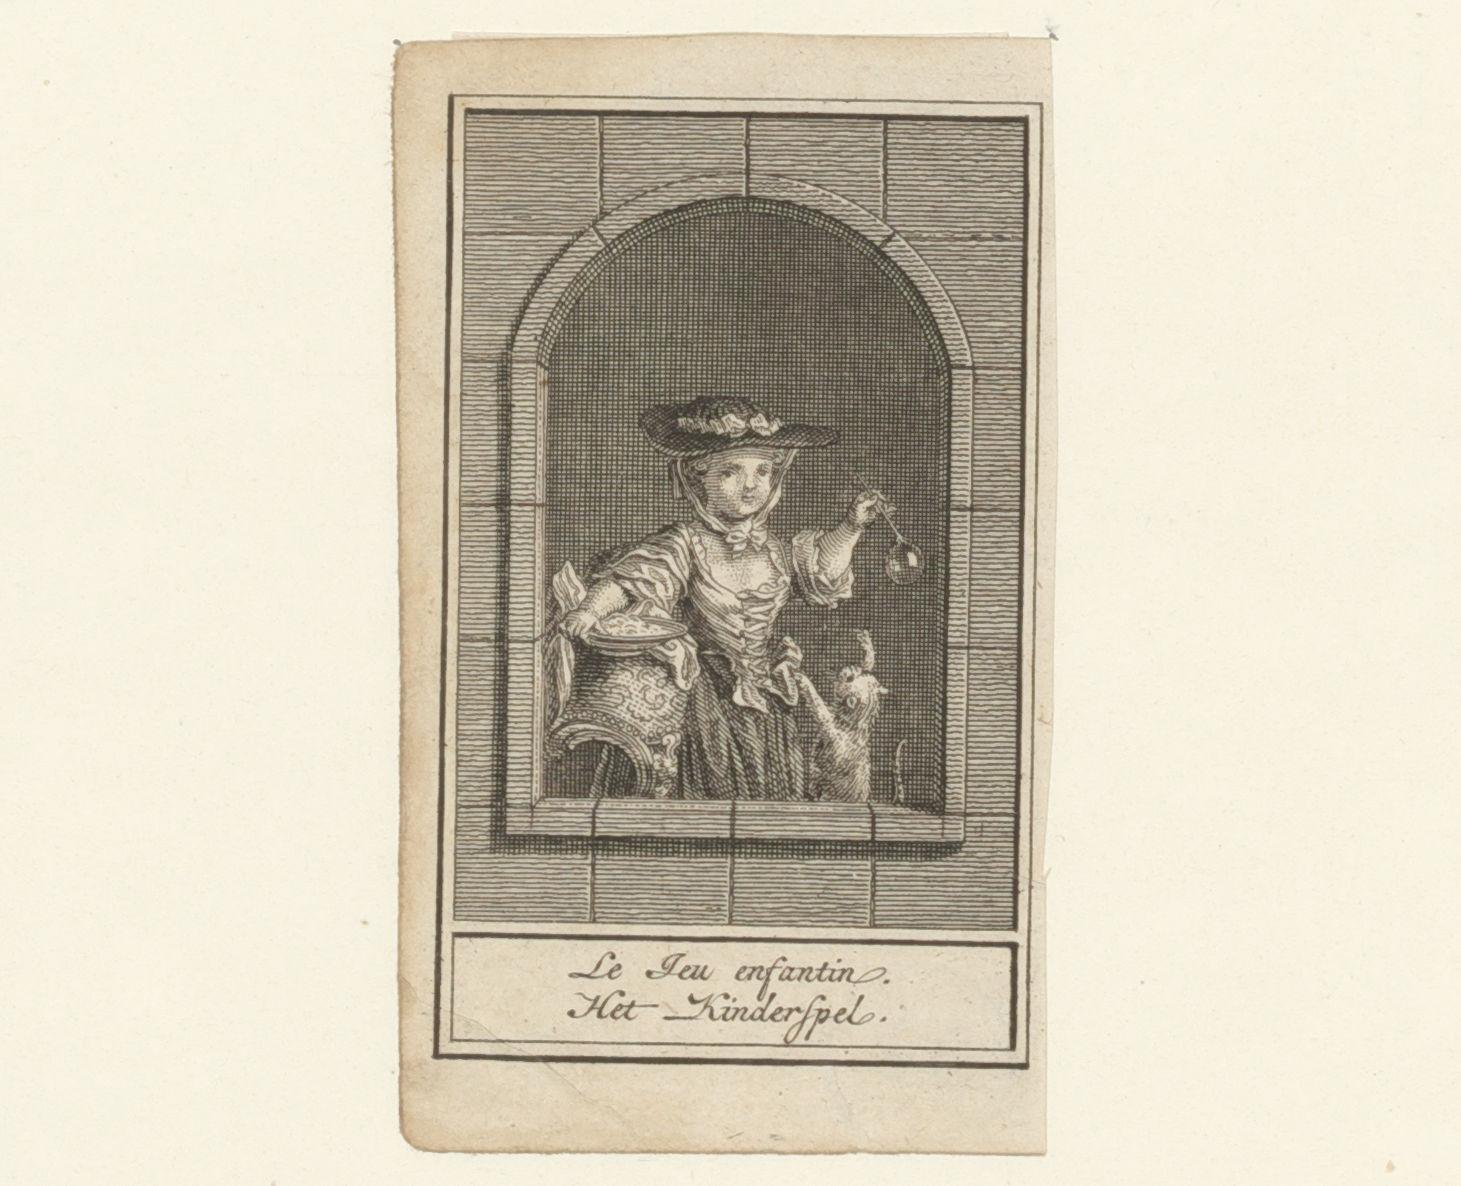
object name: print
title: Le Jeu enfantin / Het Kinderspel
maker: Anonymous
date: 1700-1799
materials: paper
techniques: engraving, etching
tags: children's games and plays, cat, soap-bubble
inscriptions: stamp, collector's mark: Lugt 1641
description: Onderwerpsrubrieken binnen de Atlas Zeden en Gewoonten: Zeden en Gewoonten in Engeren Zin, Des menschen beging, midden en einde, Kinderleven – Kinderspel en Kinderprenten.